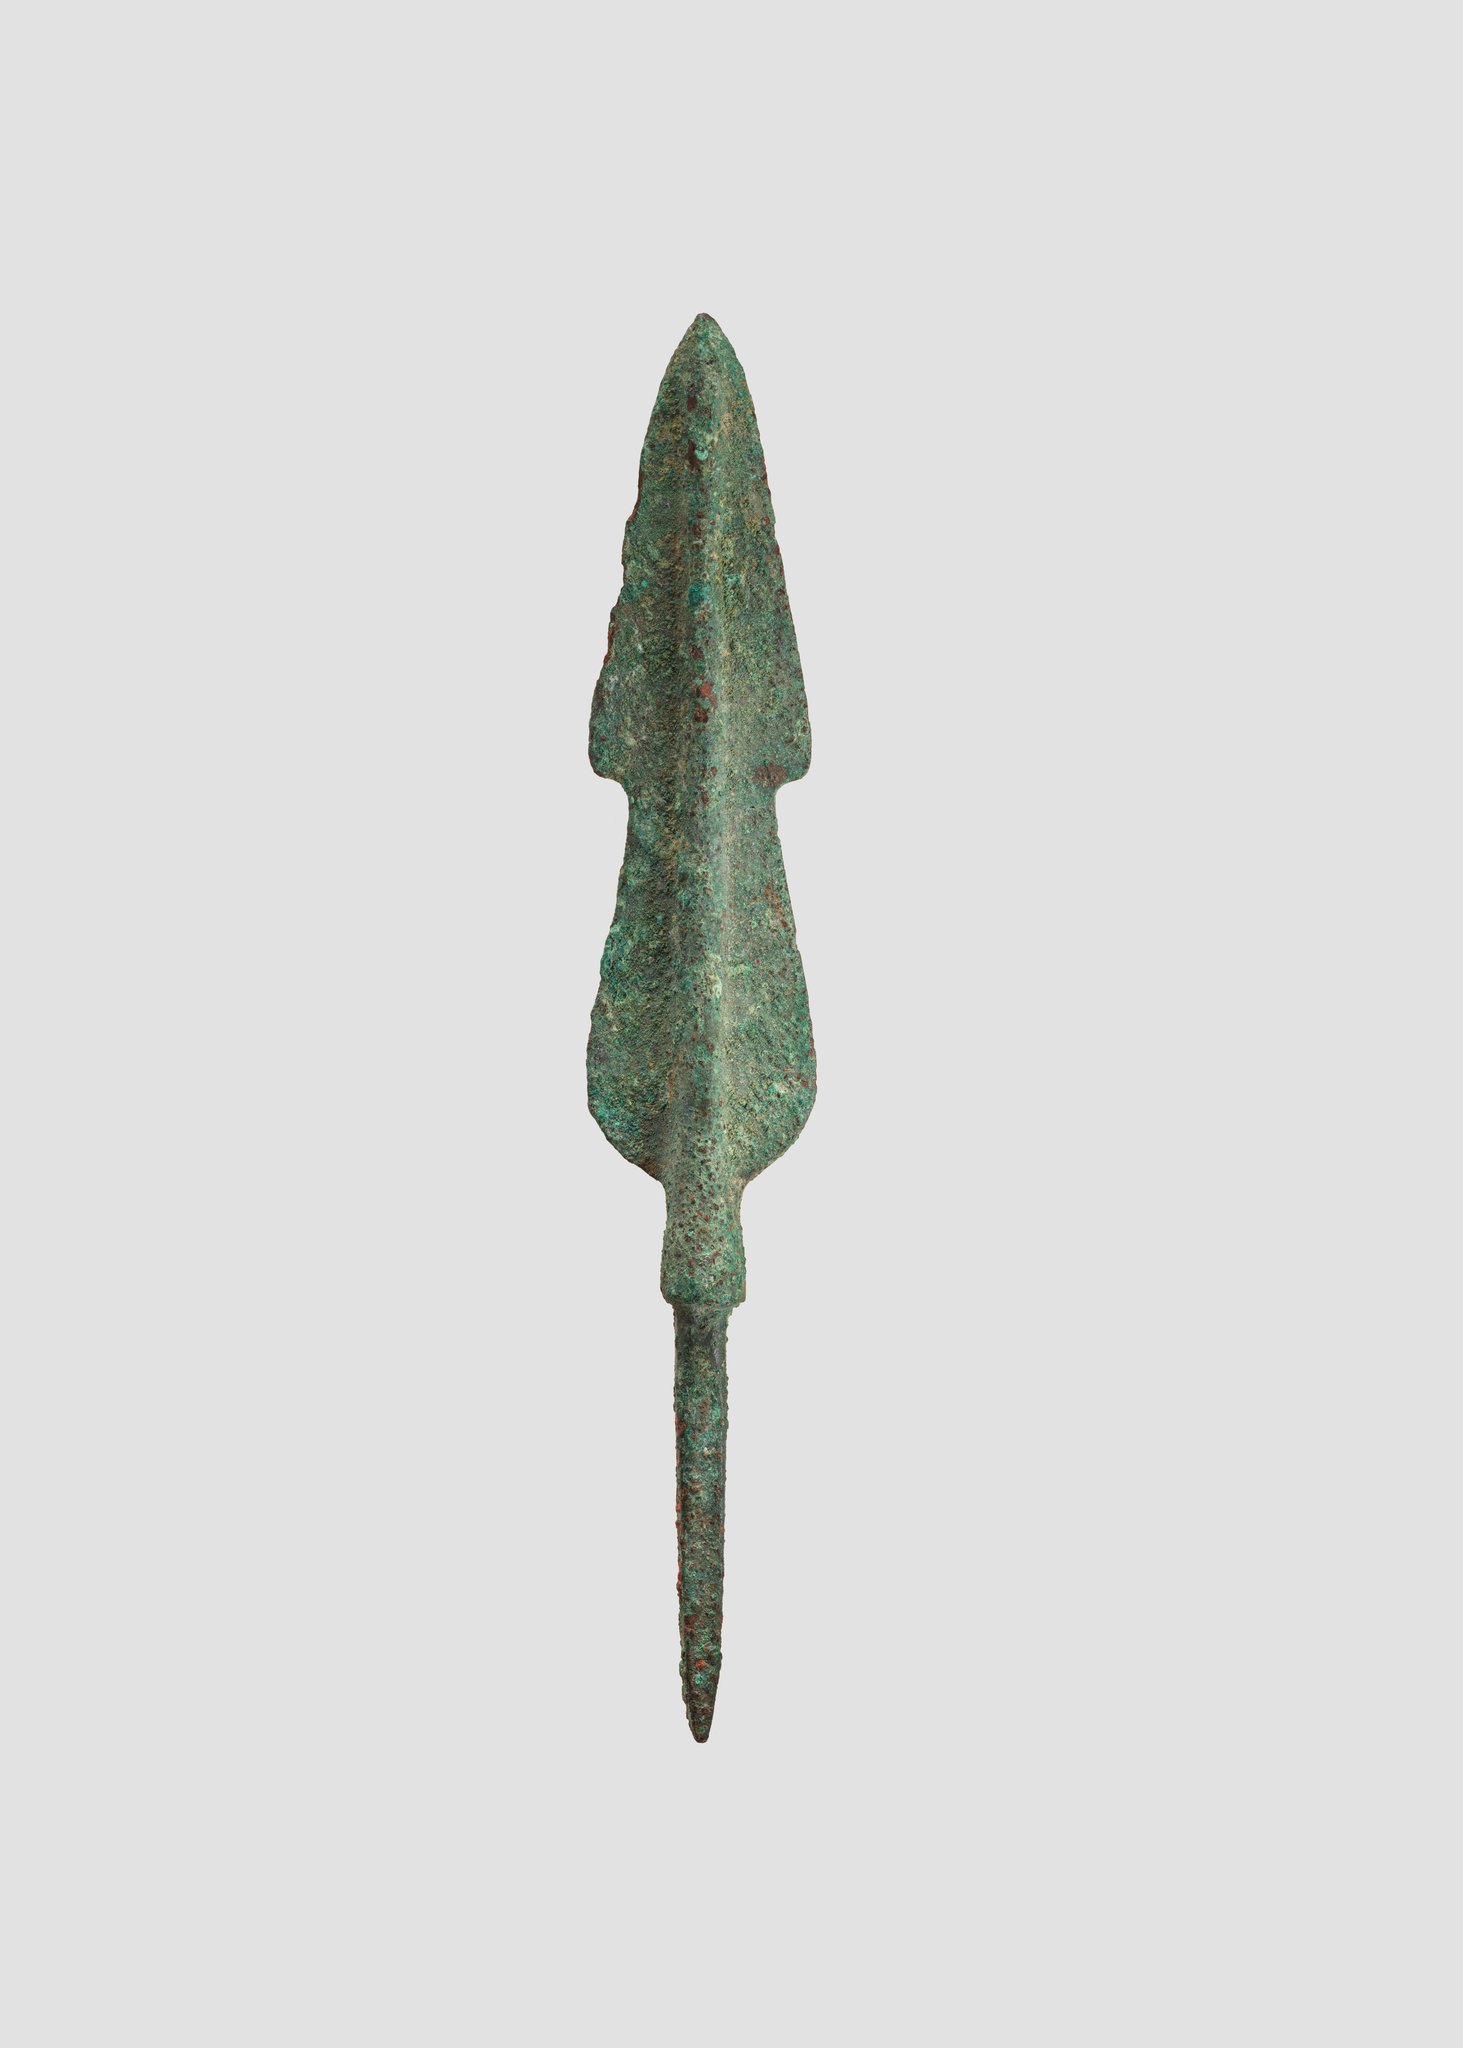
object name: arrowhead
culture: iranian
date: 2000-1 BCE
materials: bronze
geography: iran